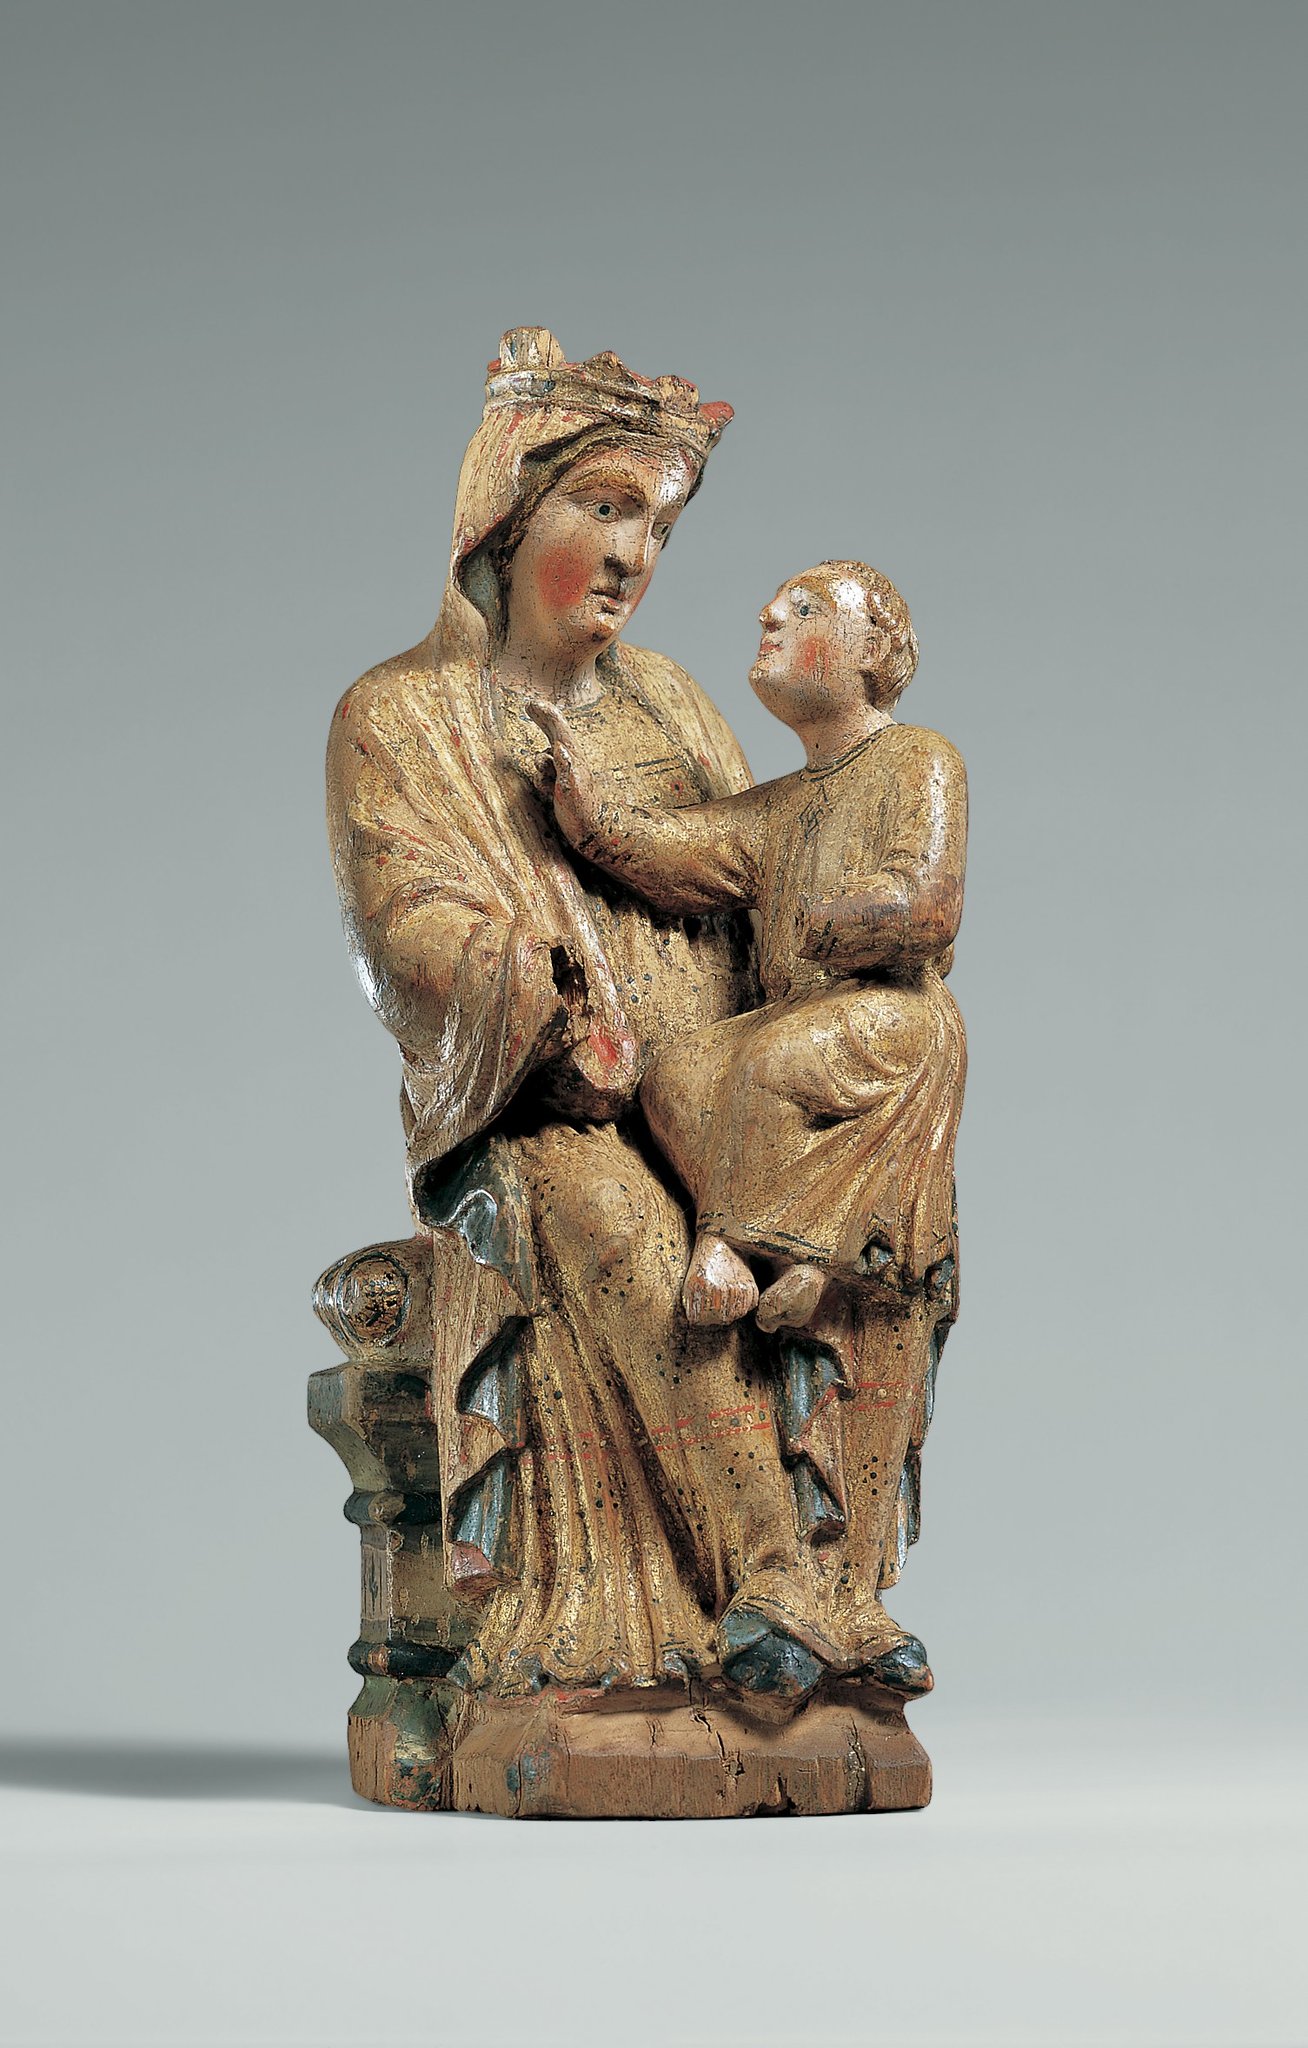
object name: statuette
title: Enthroned Virgin and Child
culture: mosan or lower rhenish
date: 1220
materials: paint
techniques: gilding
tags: madonna and child